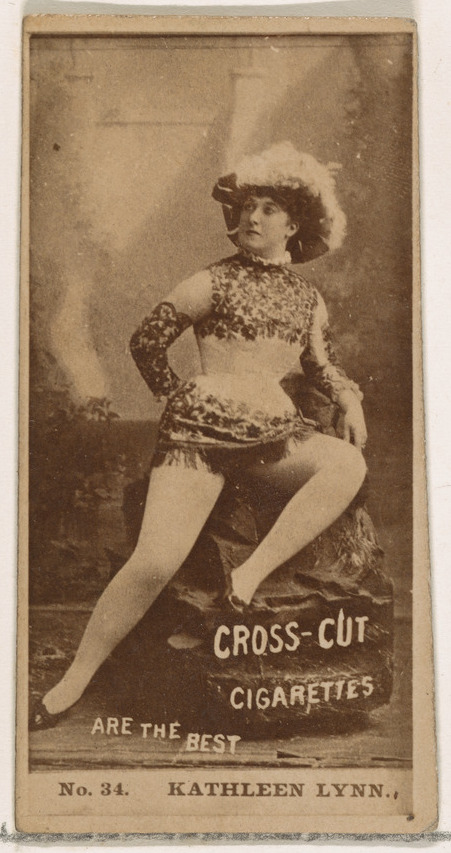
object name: print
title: Card Number 34, Kathleen Lynn, from the Actors and Actresses series (N145-2) issued by Duke Sons & Co. to promote Cross Cut Cigarettes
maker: w. duke, sons & co.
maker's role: publisher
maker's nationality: american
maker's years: 1870-1920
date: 1880-1889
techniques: albumen silver print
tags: portraits,women,actresses